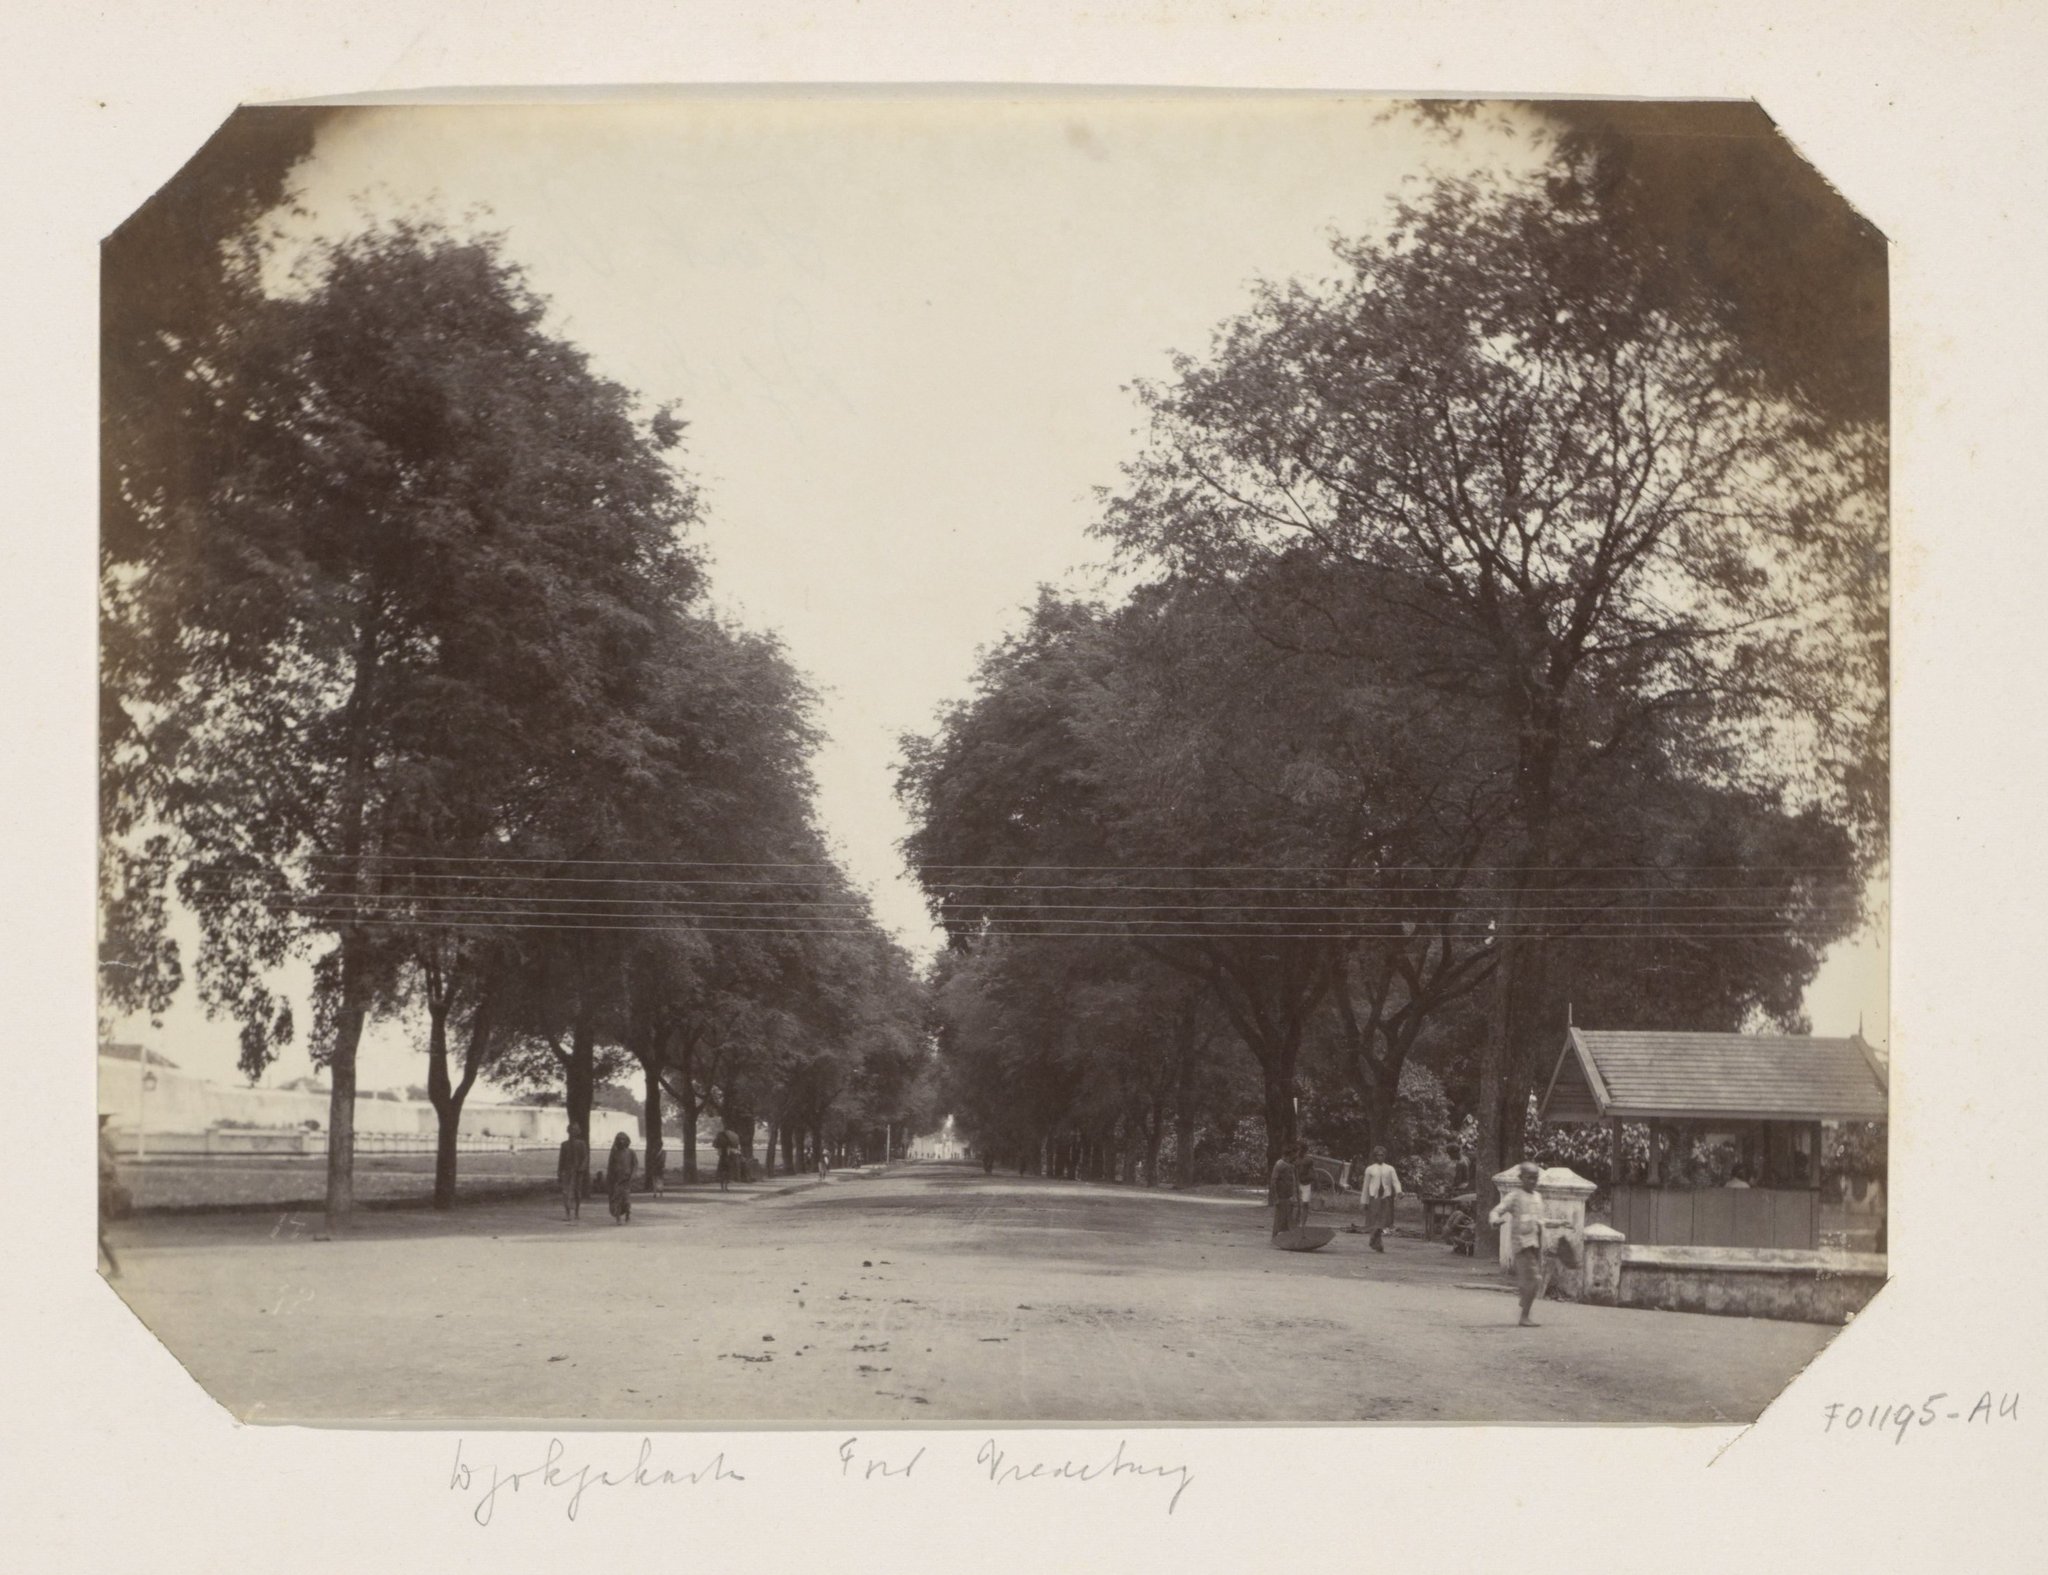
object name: photograph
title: Laan bij Fort Vredeburg in Jogyakarta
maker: Anonymous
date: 1880-1900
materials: cardboard, paper, photographic support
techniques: albumen print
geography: jogjakarta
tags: fortress, dutch east indies, the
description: Onderdeel van Fotoalbum van een reis door de Verenigde Staten, Honolulu, Nederlands-Indië, Aden, Zanzibar en Zuidelijk Afrika.